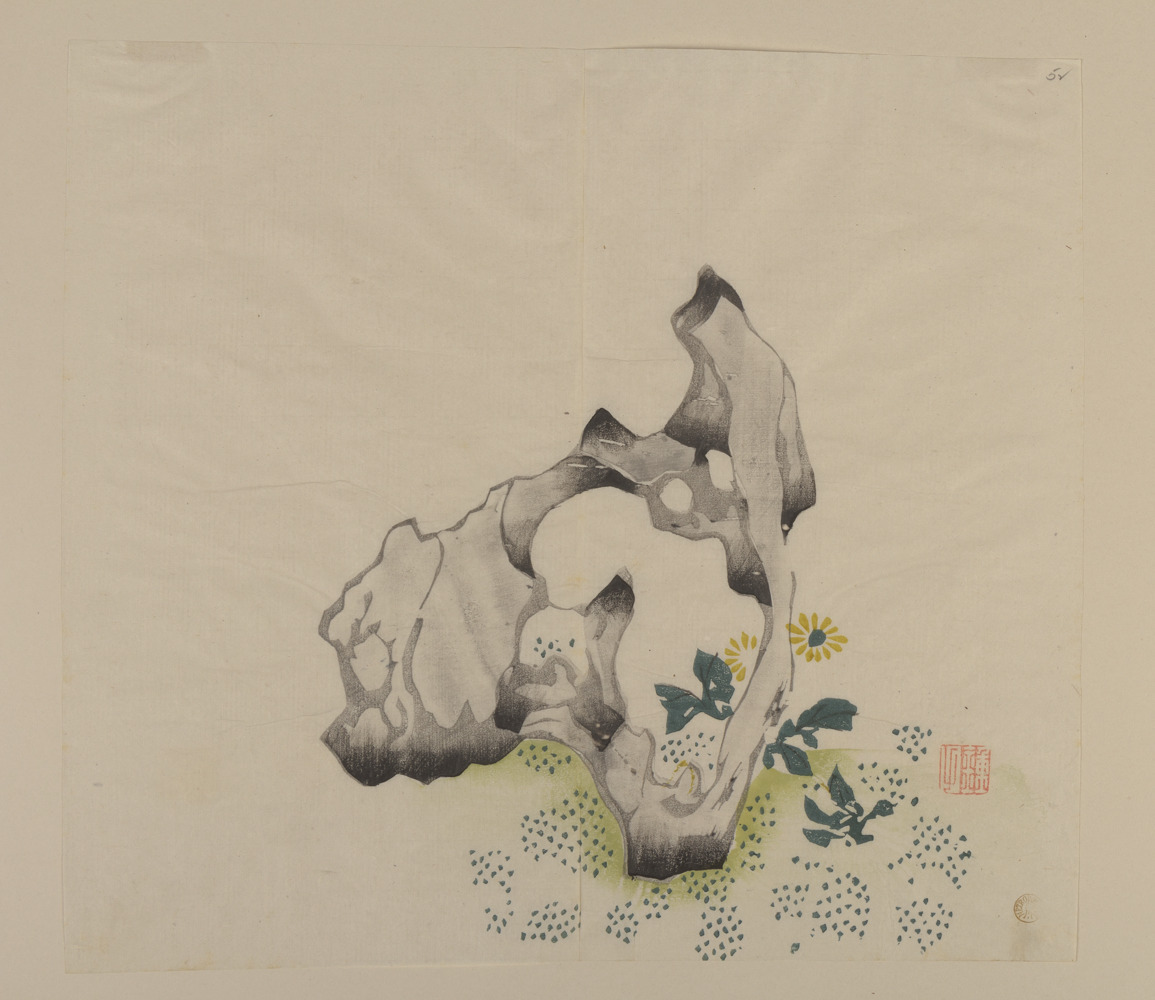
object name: print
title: Page from Shi Zhu Zhai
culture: chinese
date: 1736-1795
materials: ink, paper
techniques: polychrome, woodblock print